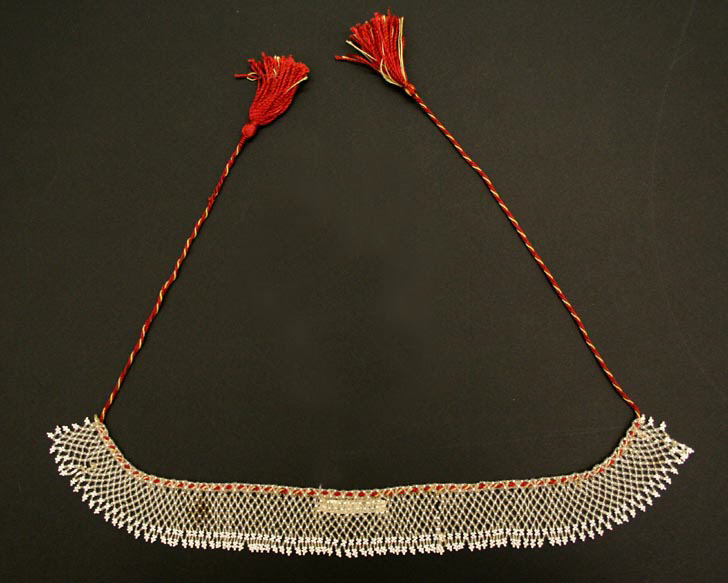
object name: collar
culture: american or european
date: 1870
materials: glass, silk